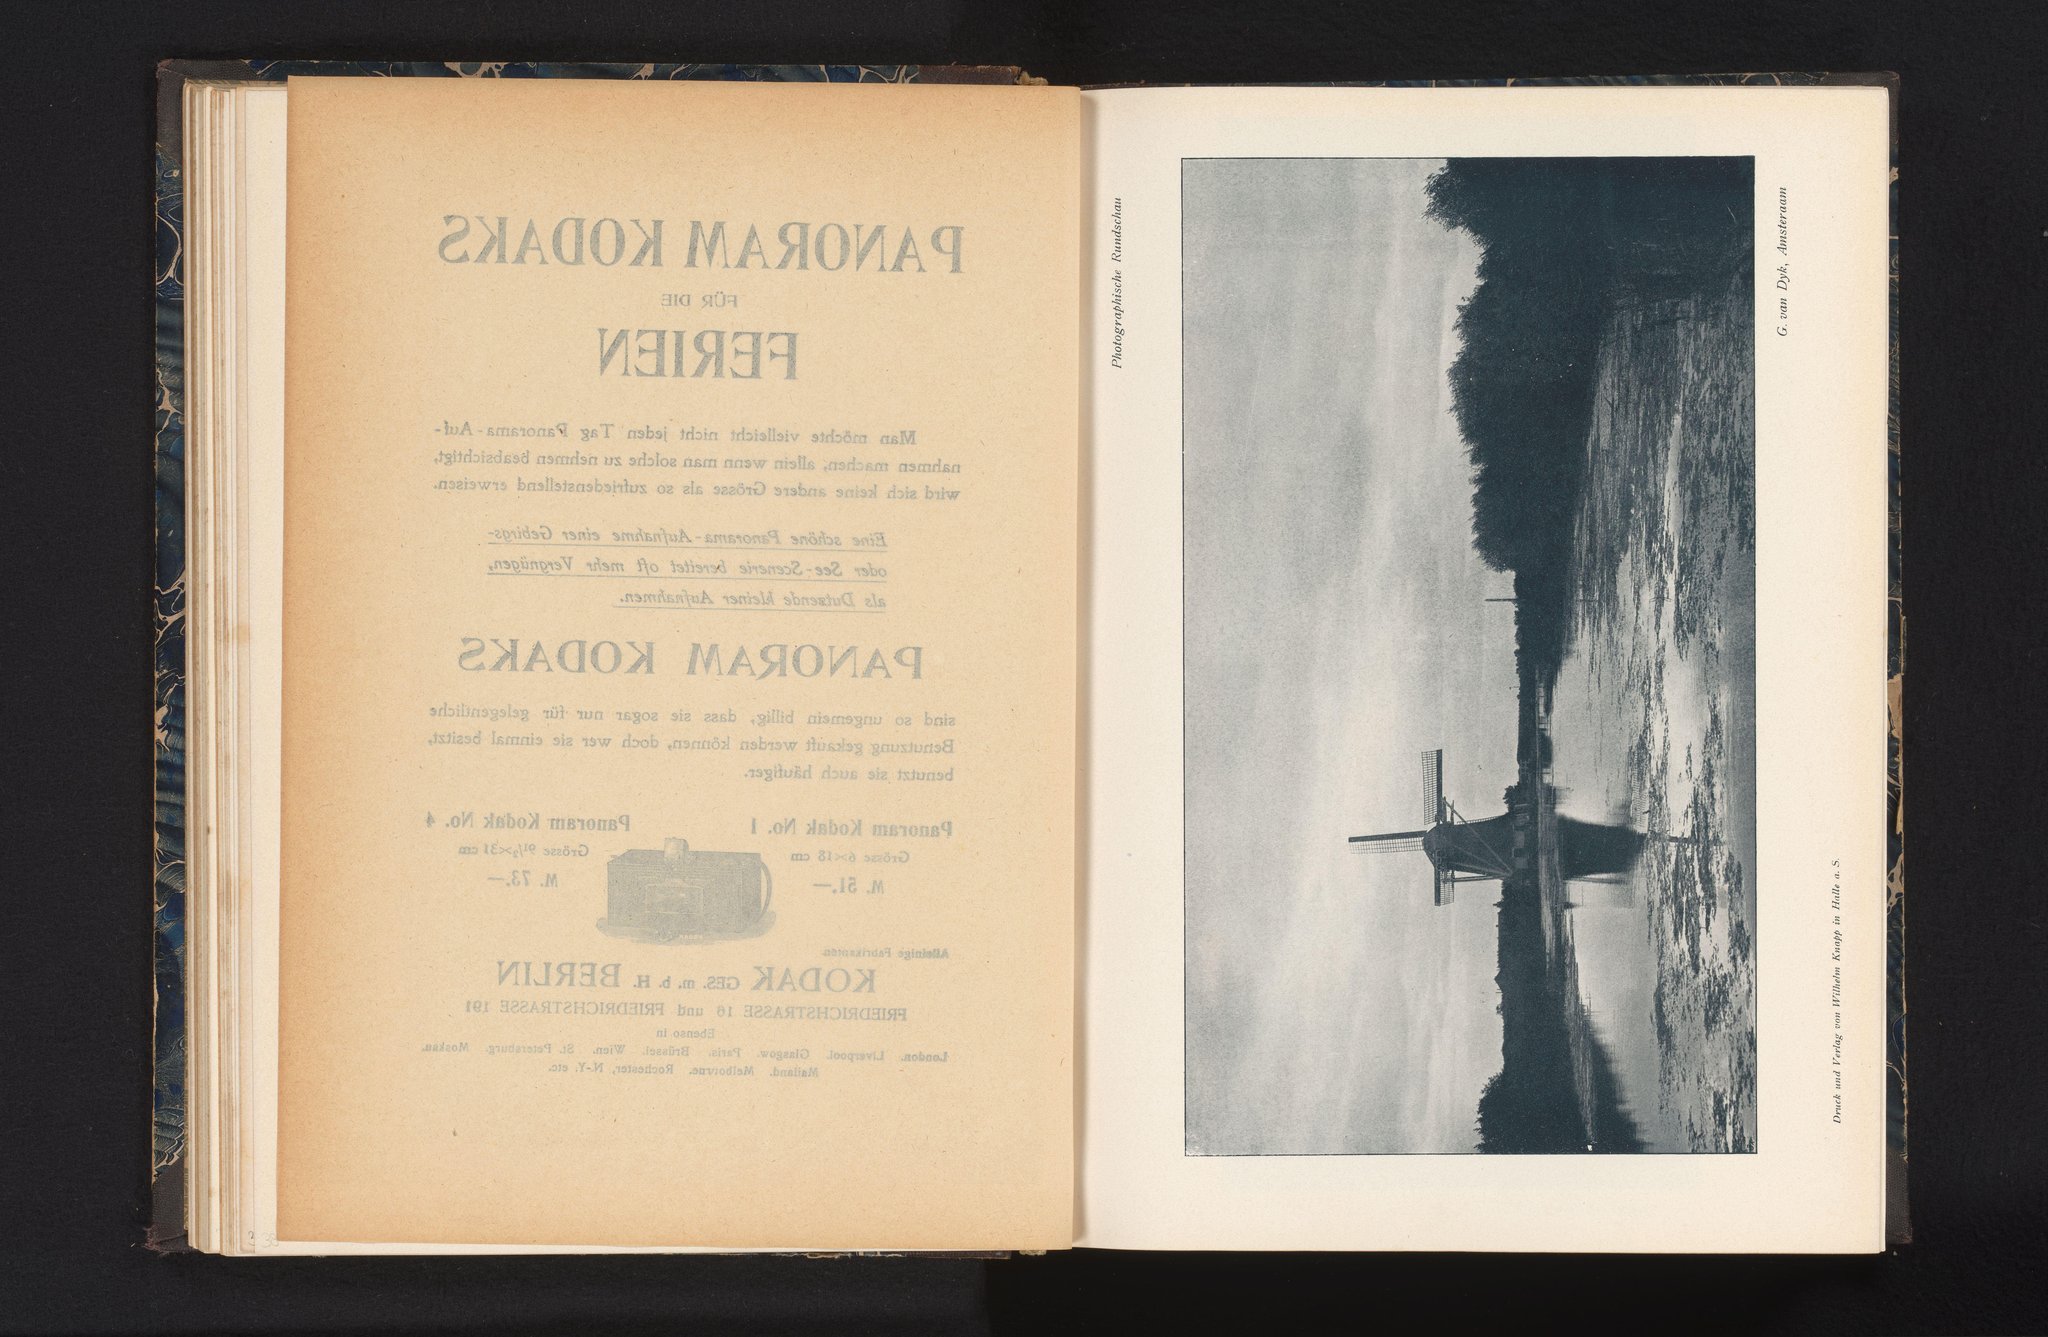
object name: photomechanical print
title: Gezicht op een sloot en een molen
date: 1897-1902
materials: paper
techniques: autotype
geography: halle an der saale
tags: windmill, small canal, ditch